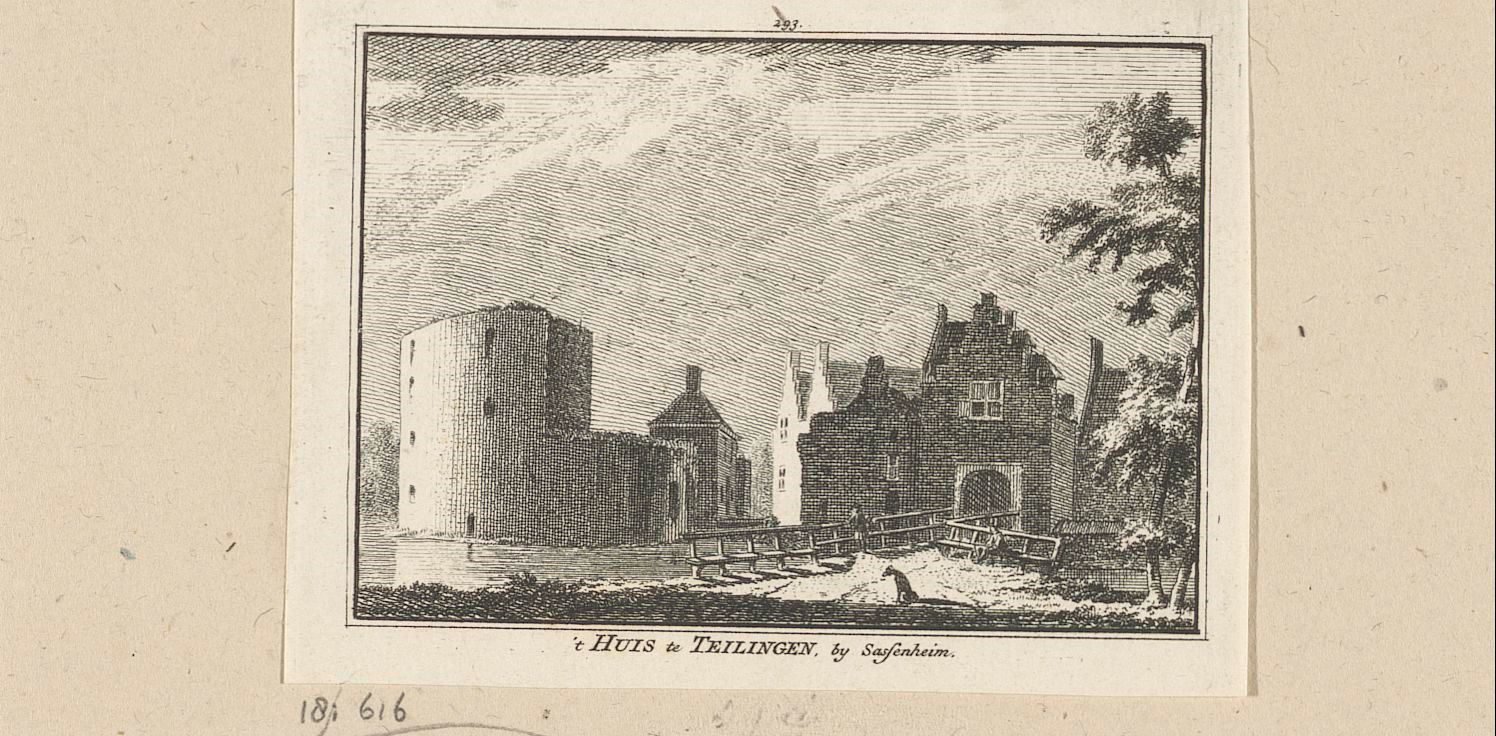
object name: book illustration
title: Gezicht op de ruïne van Slot Teylingen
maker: hendrik spilman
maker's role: draughtsman, painter, print maker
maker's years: 1721-1784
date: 1750-1792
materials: paper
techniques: engraving, etching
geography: haarlem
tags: bridge, ruin of a dwelling, house, castle, etc.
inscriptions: collector's mark: Lugt 2228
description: Prent ook gebruikt in: Het verheerlykt Nederland of kabinet van hedendaagsche gezigten van steden, dorpen (…). 9 delen. Amsterdam: Isaak Tirion en weduwe Isaak Tirion, 1745-1774, dl. 3 (1750), ill. 293. Of in: Nederlandsche tafereelen; of eene keurige verzameling van negen honderd fraaije gezigten van steden, dorpen, sloten, oudheden (….). 9 delen. Amsterdam: Jan de Groot, 1792, dl. 3, ill. 293.